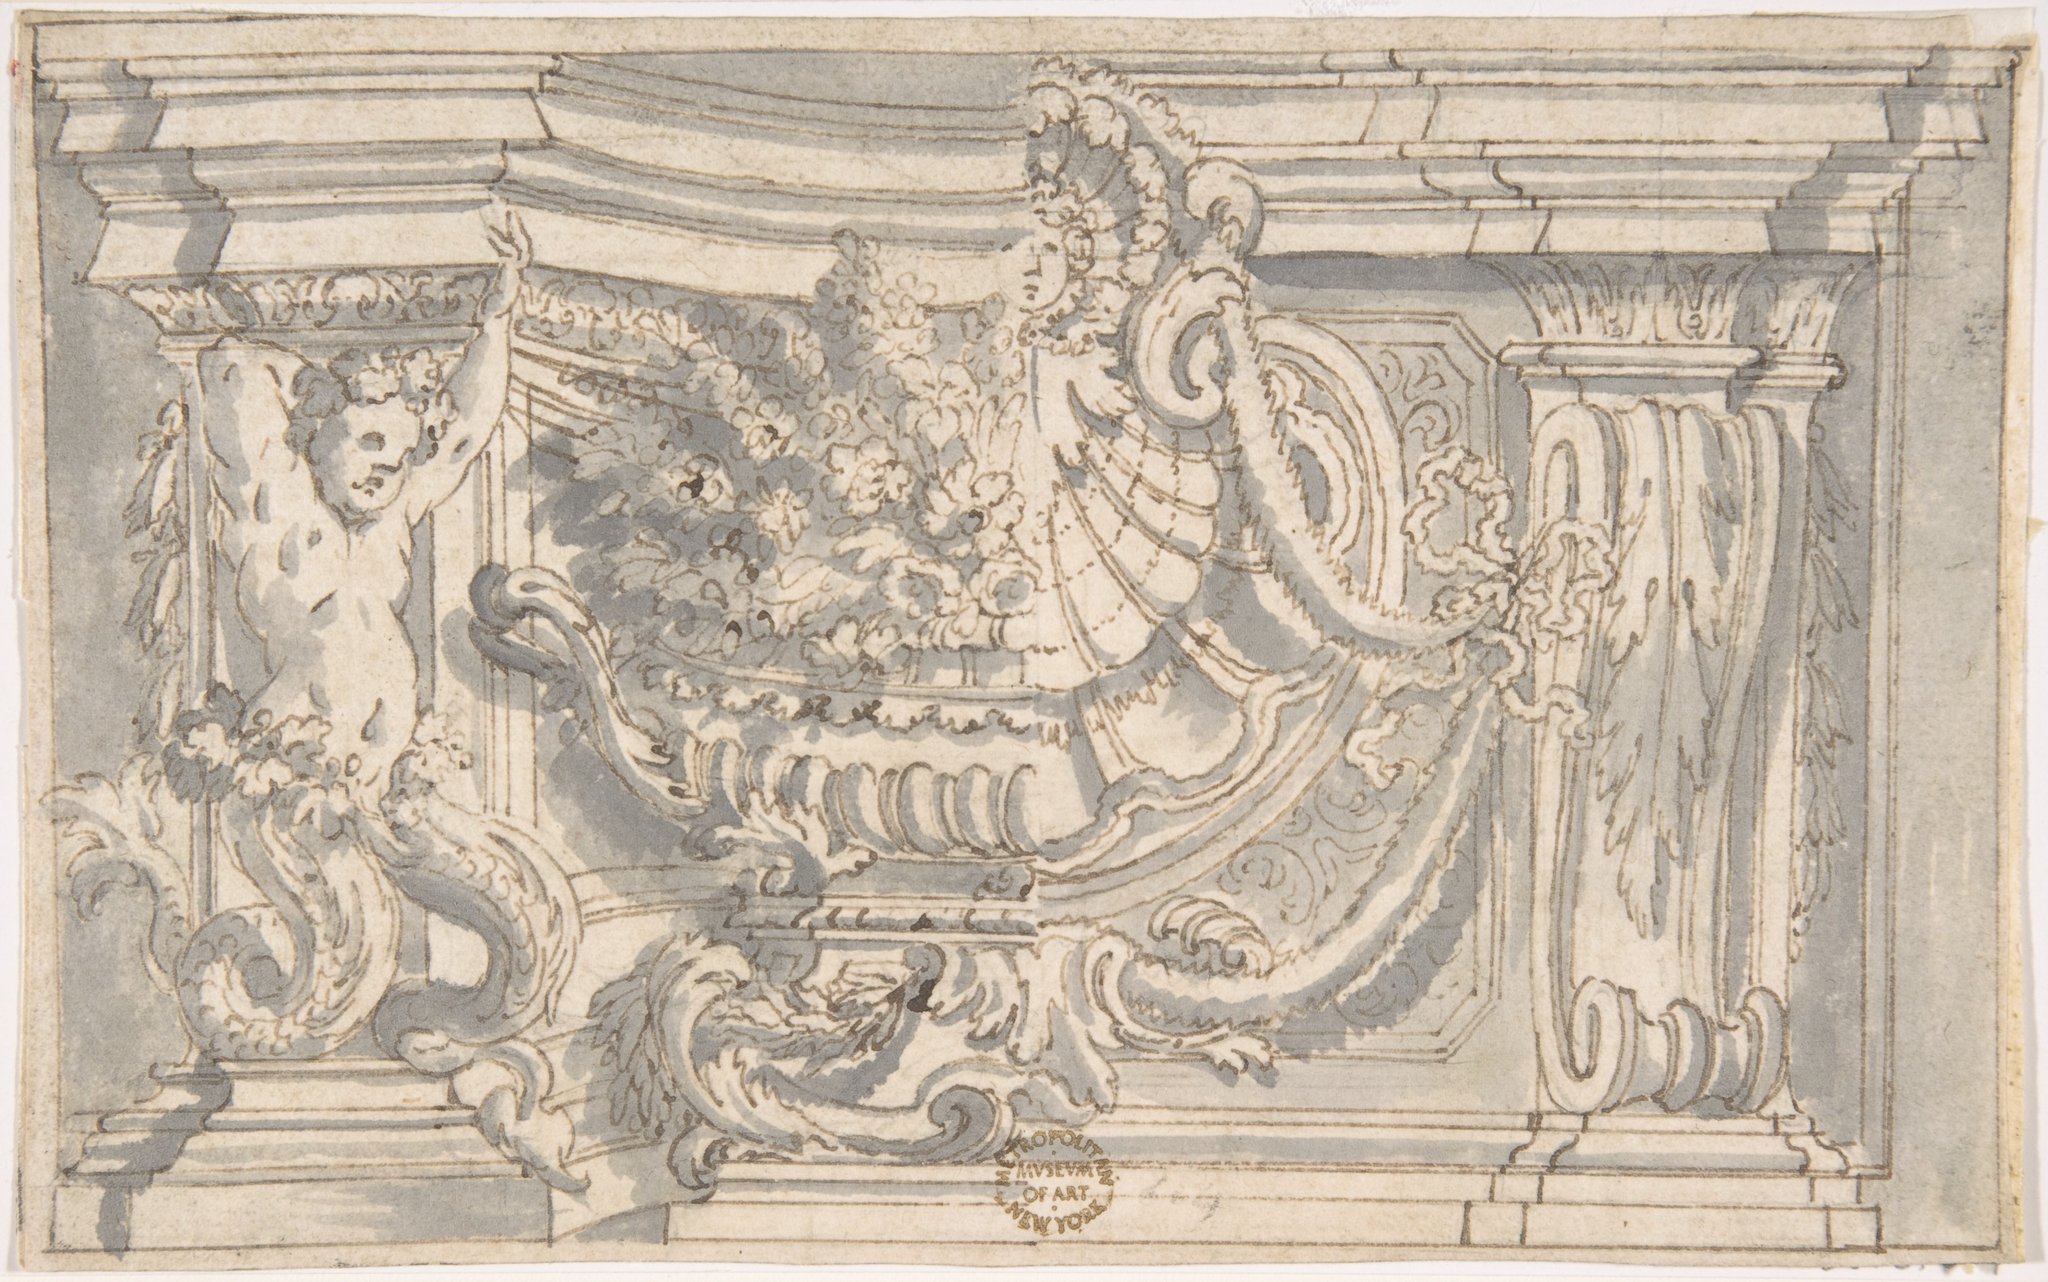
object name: drawing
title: Drawing Showing Two Alternate Designs for an Ornamental Niche or Panel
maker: anonymous, italian, roman-bolognese, 17th century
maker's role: artist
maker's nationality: italian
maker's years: 1600-1700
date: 1601-1700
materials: chalk, ink, paper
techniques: brush, pen, wash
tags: ornament